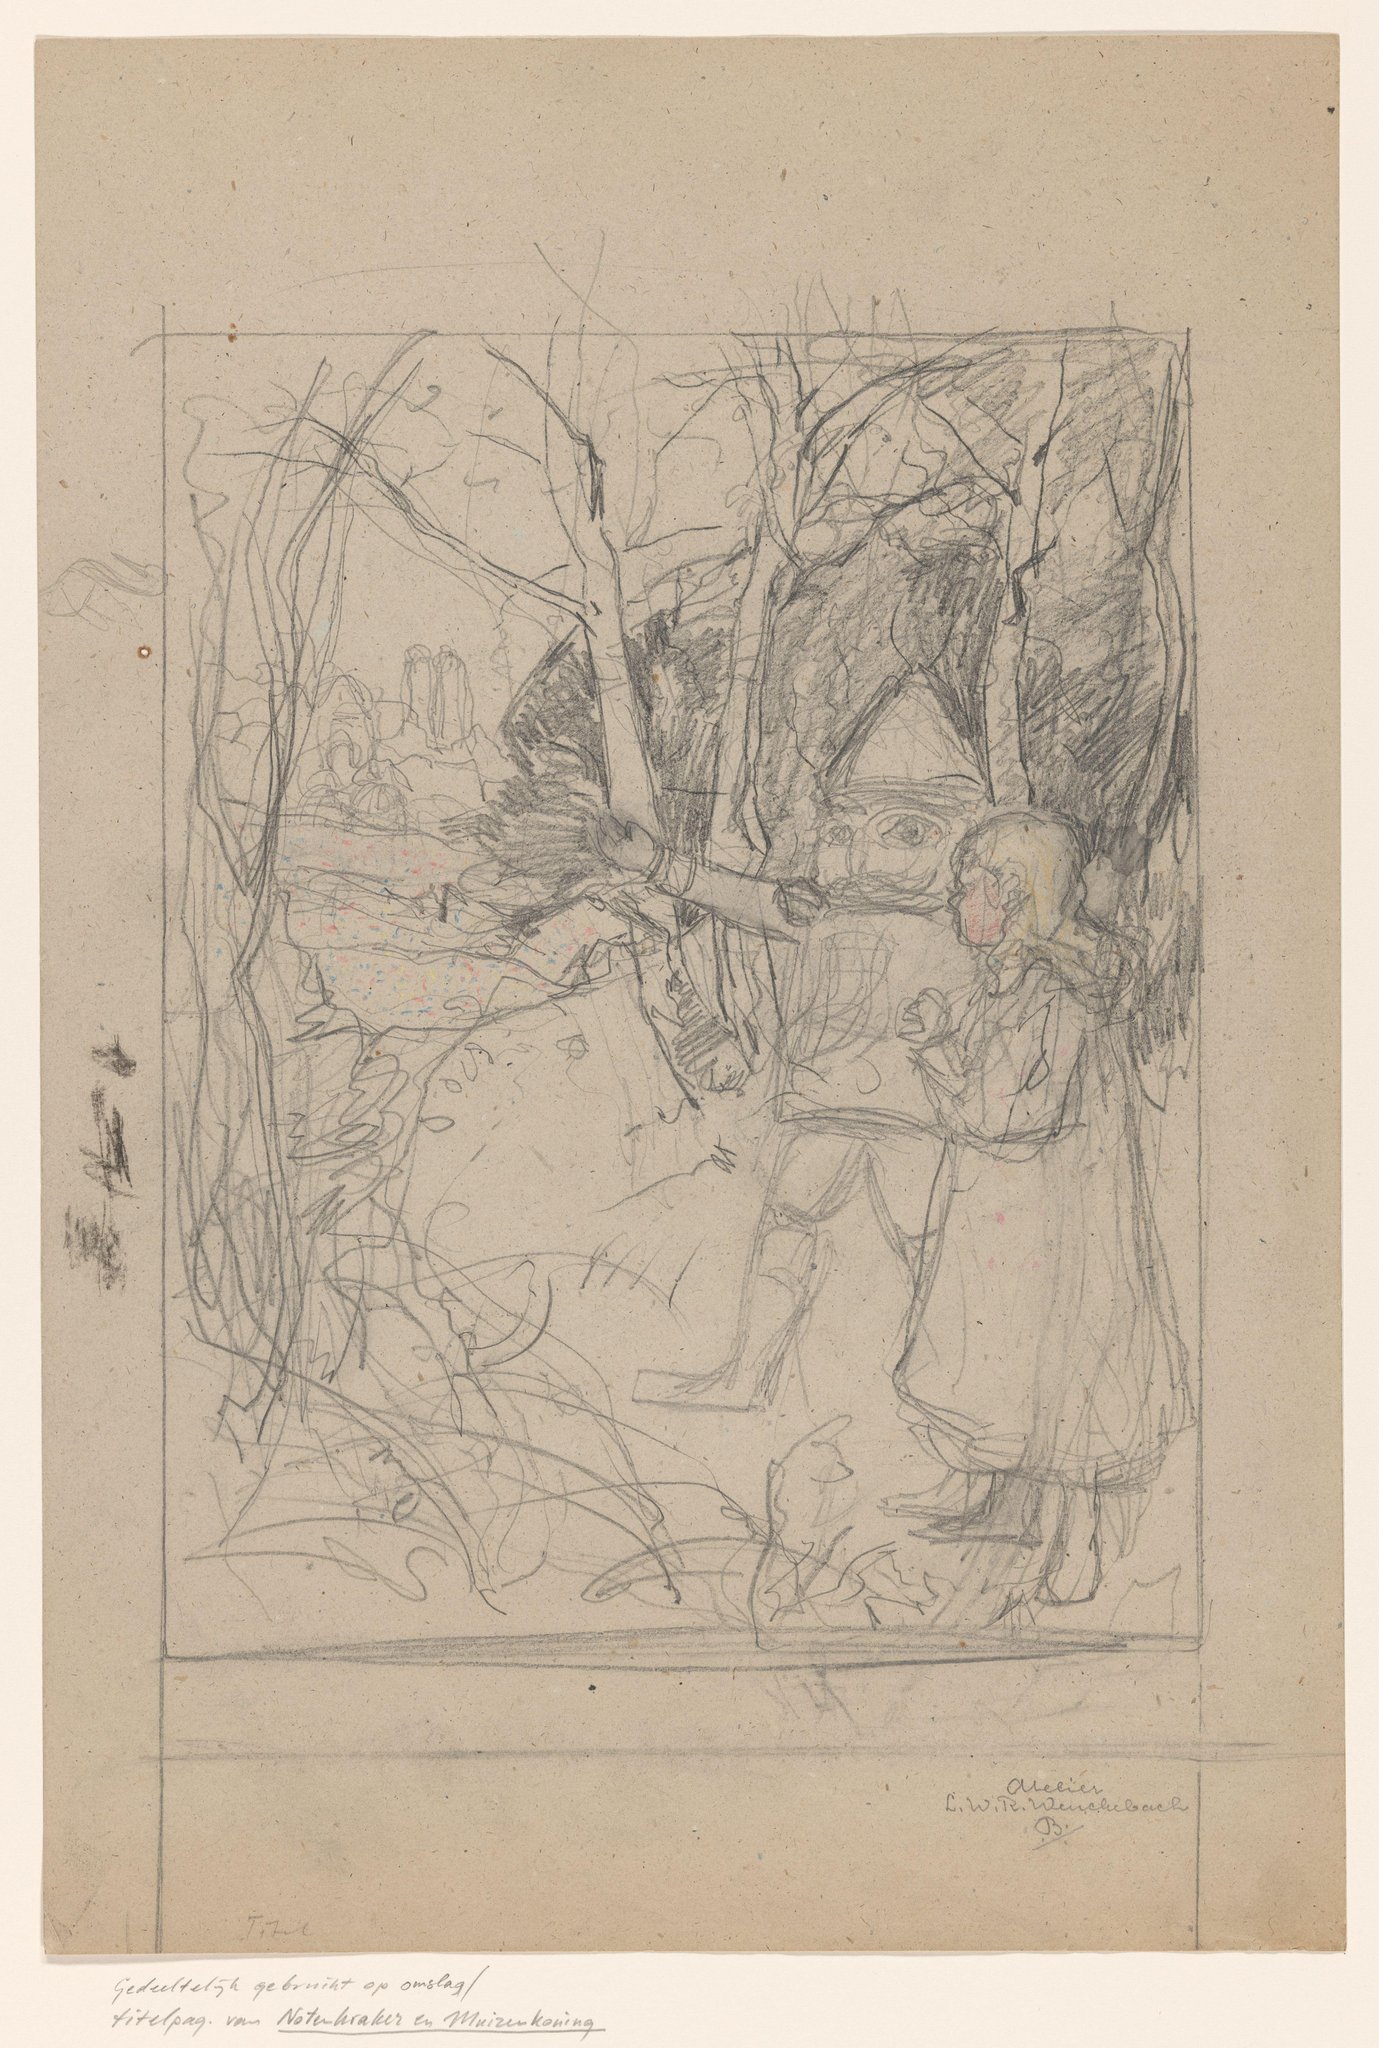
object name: study for binding design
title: Bandontwerp voor: E.T.A. Hoffmann, Notenkraker en muizenkoning, 1898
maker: willem wenckebach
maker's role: designer, draughtsman, painter, print maker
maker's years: 1860-1937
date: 1898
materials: chalk, paper, pencil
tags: (playing with) dolls, forest path or lane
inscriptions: collector's mark: Lugt 2228a, annotation: ‘T. [...]’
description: Marie en de Notenkraker staan op een pad in een bosachtige omgeving. De Notenkraker houdt zijn rechterarm opgeheven.